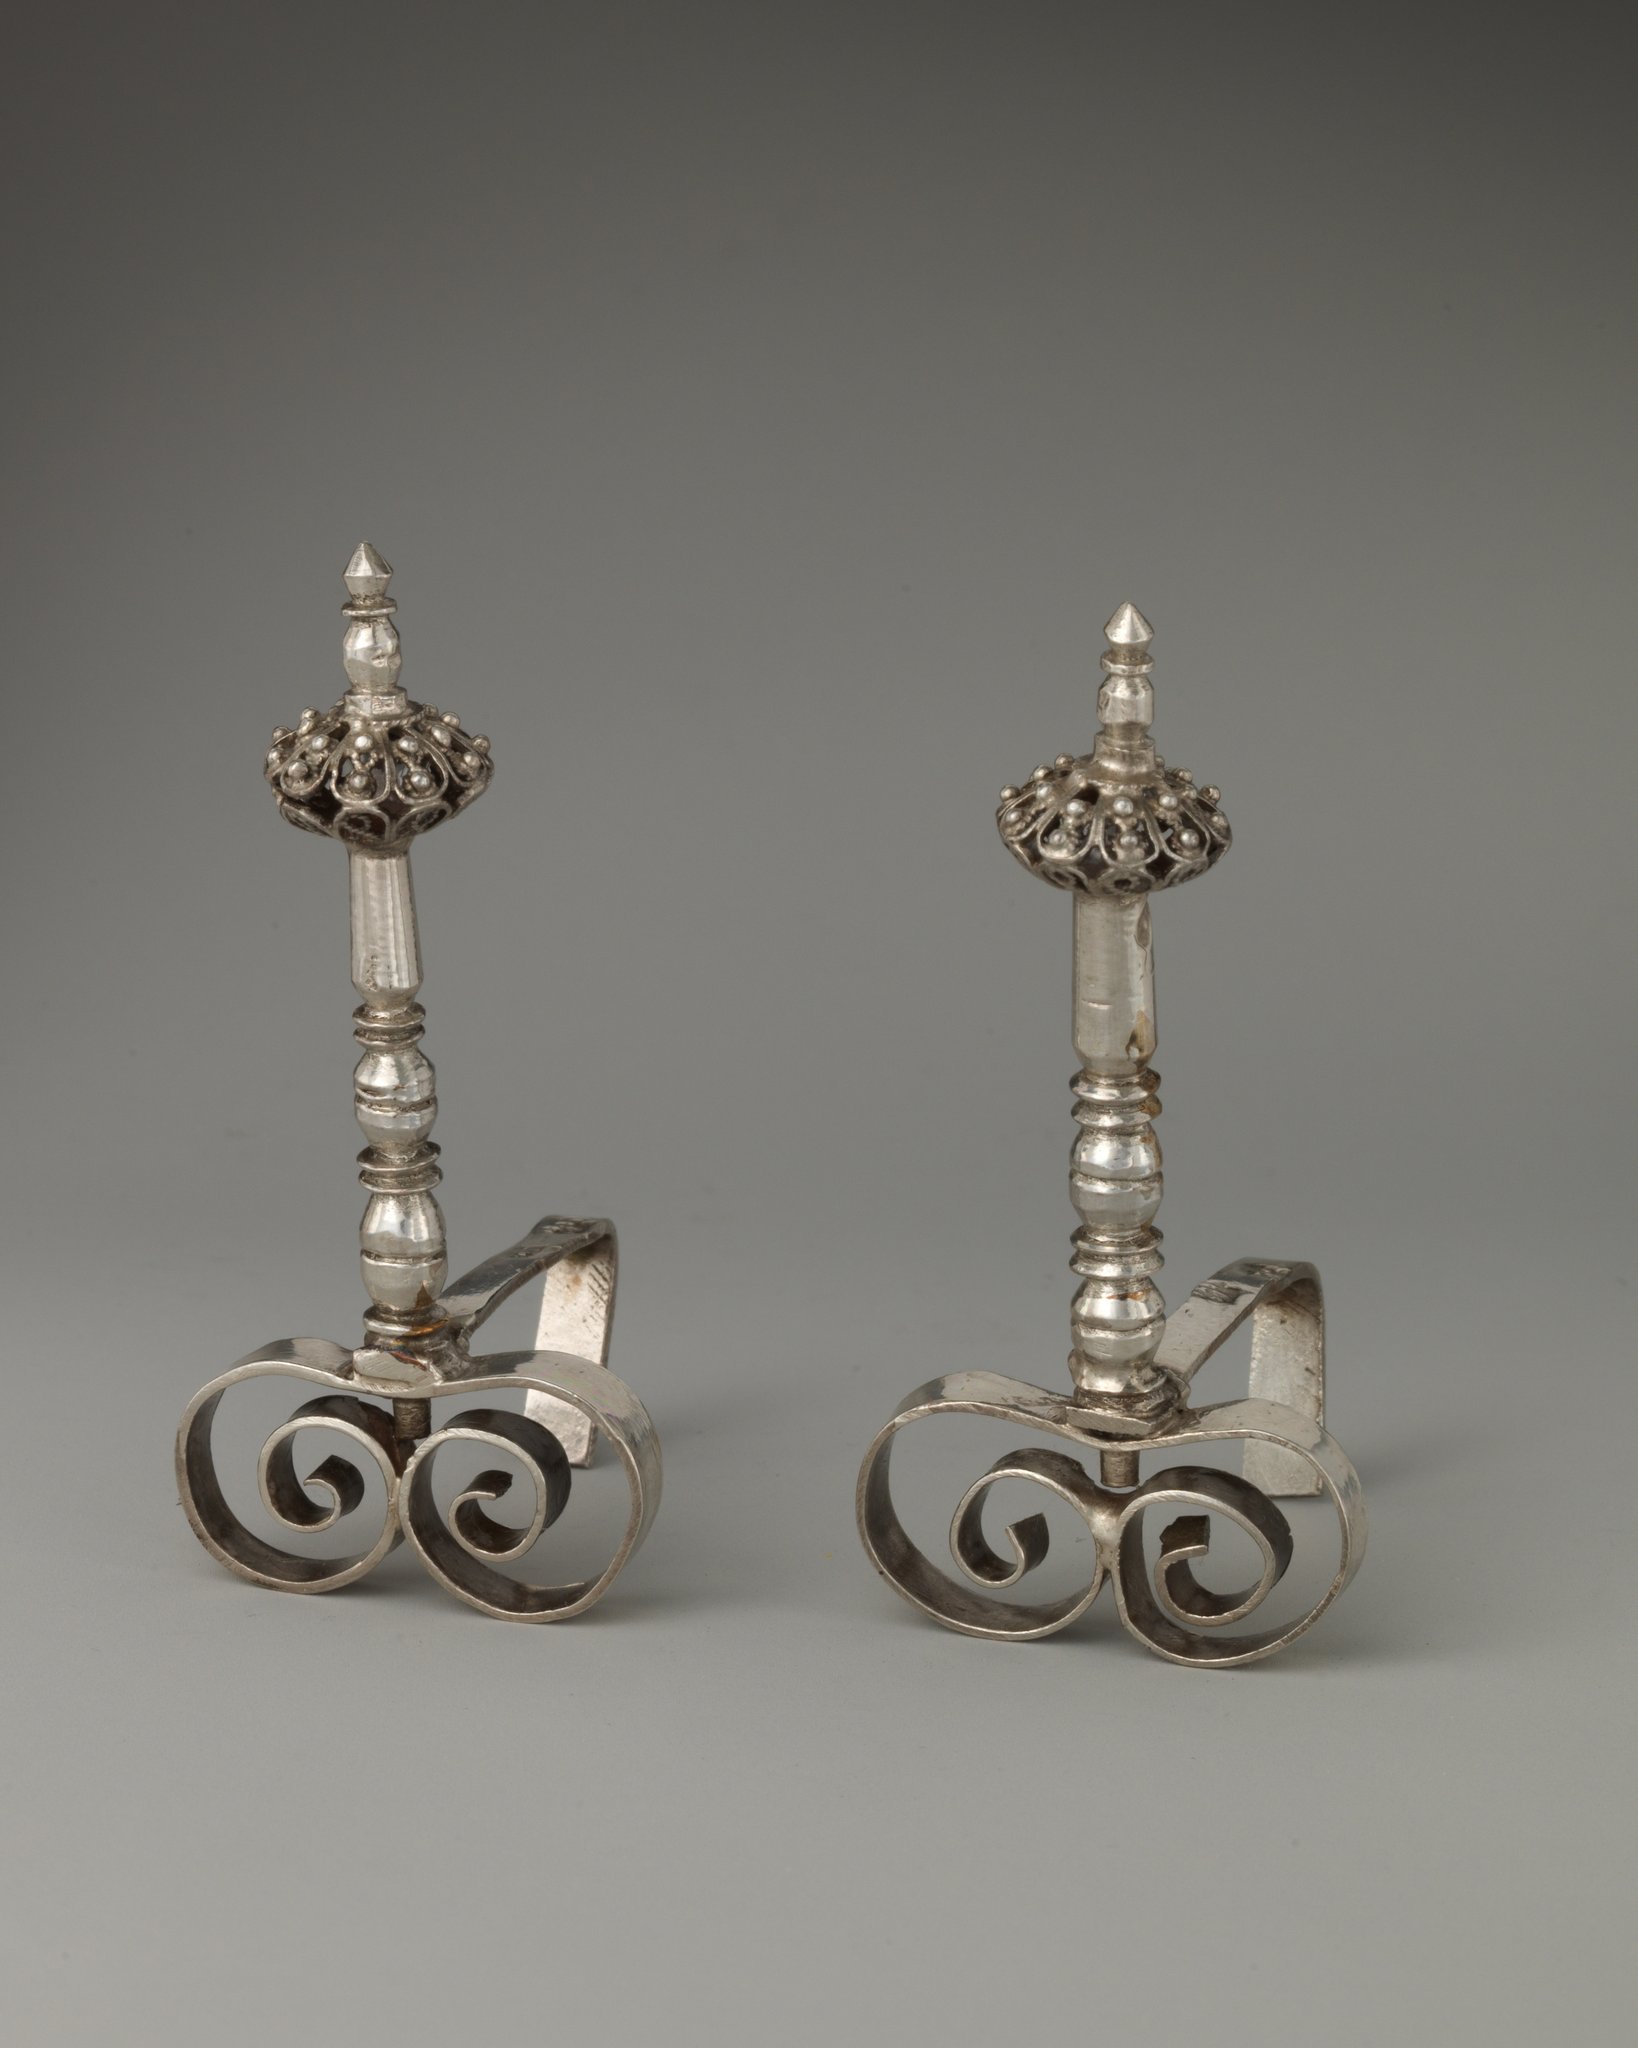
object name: andiron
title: Miniature andiron (one of a pair) (part of a set)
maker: george manjoy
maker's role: artist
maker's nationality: british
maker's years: 1685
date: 1690-1691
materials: silver